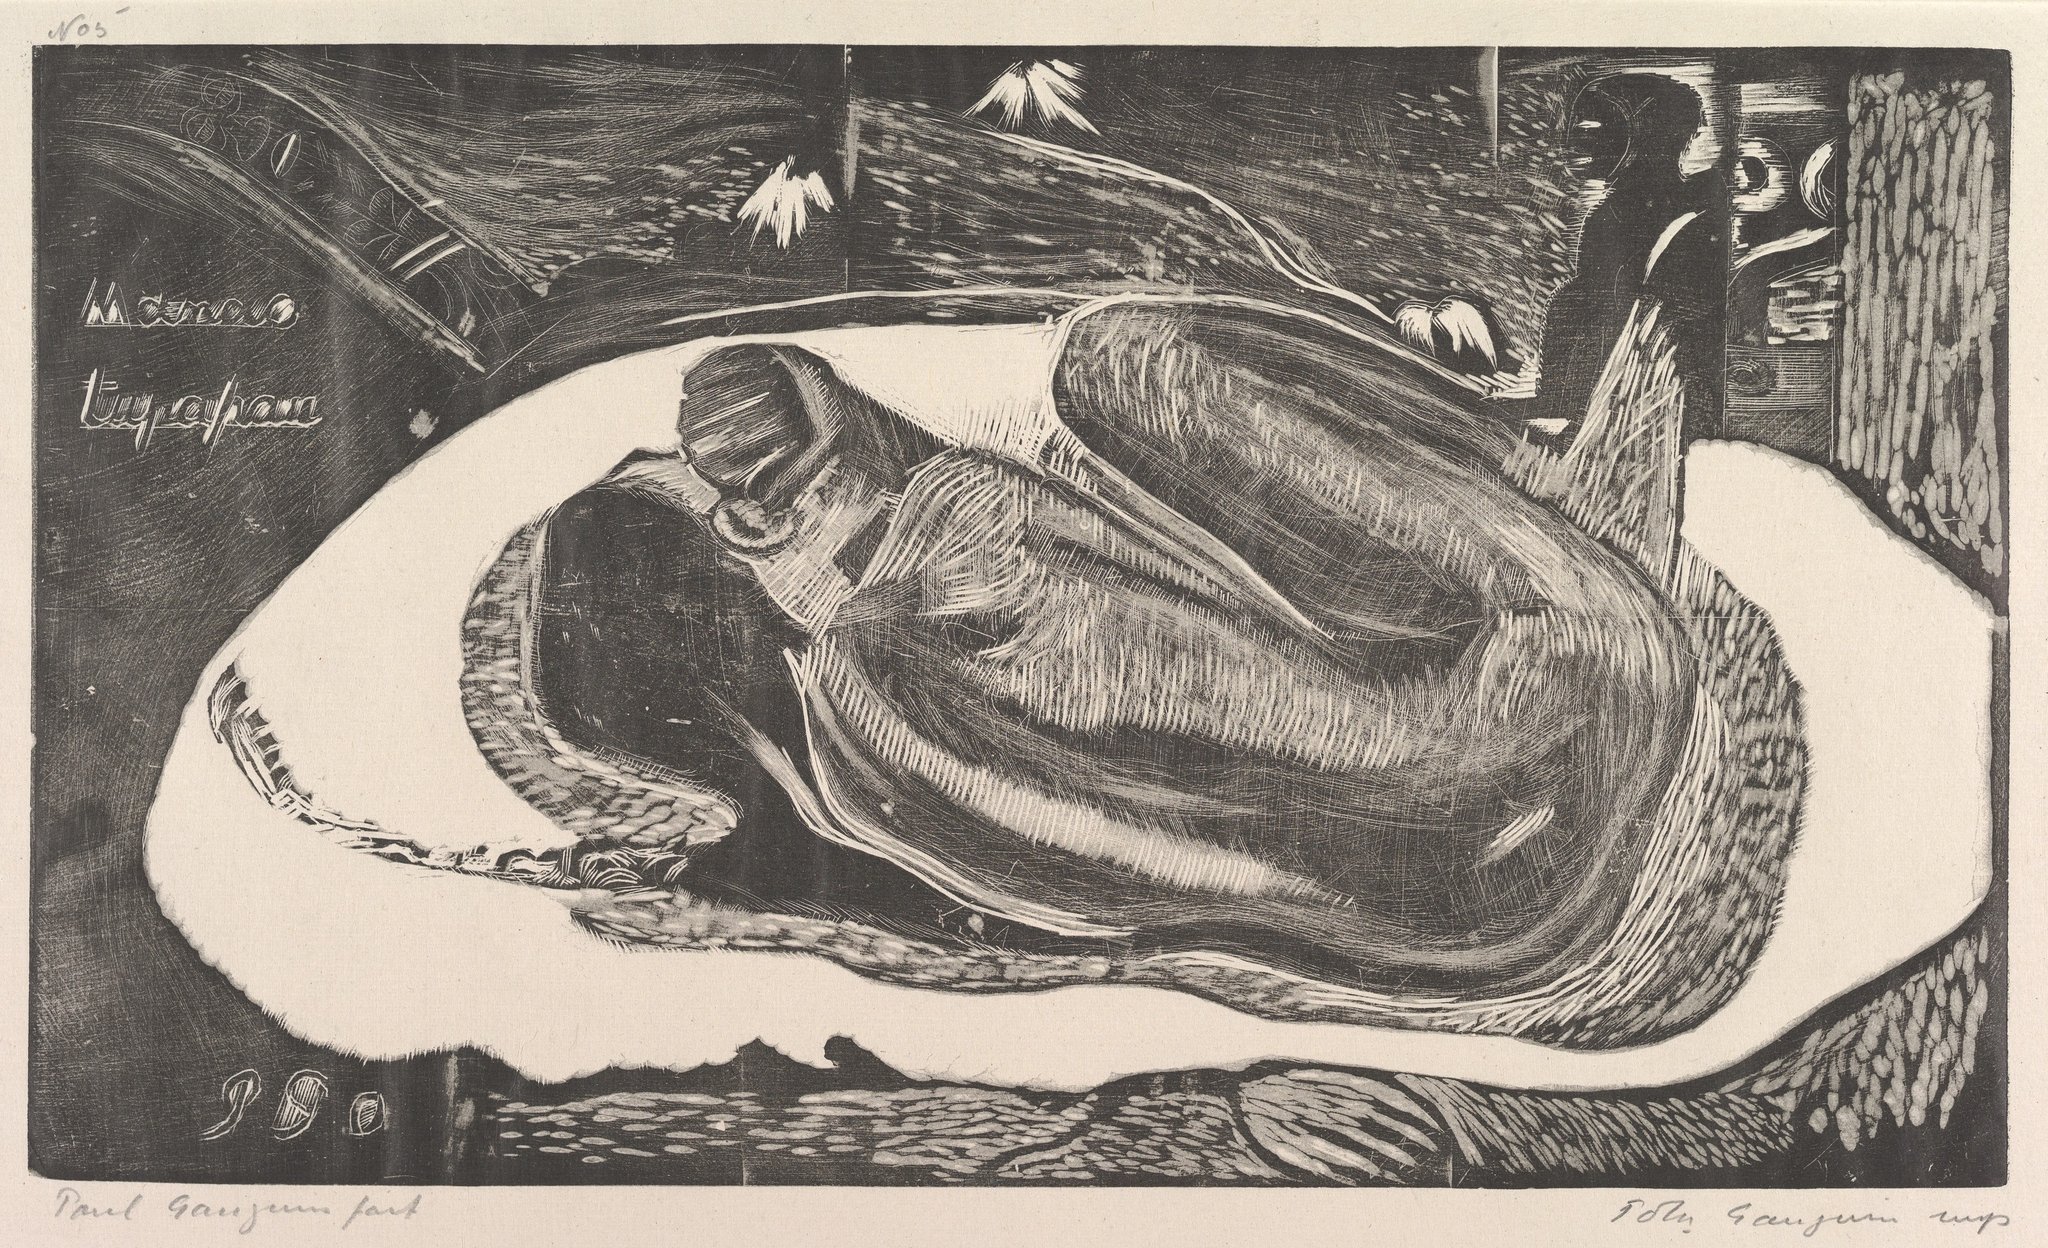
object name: print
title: Spirit of the Dead Watching (Manao Tupapau), from Fragrance (Noa Noa)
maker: paul gauguin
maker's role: artist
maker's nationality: french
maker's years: 1848-1903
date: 1893-1894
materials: paper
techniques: woodcut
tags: women